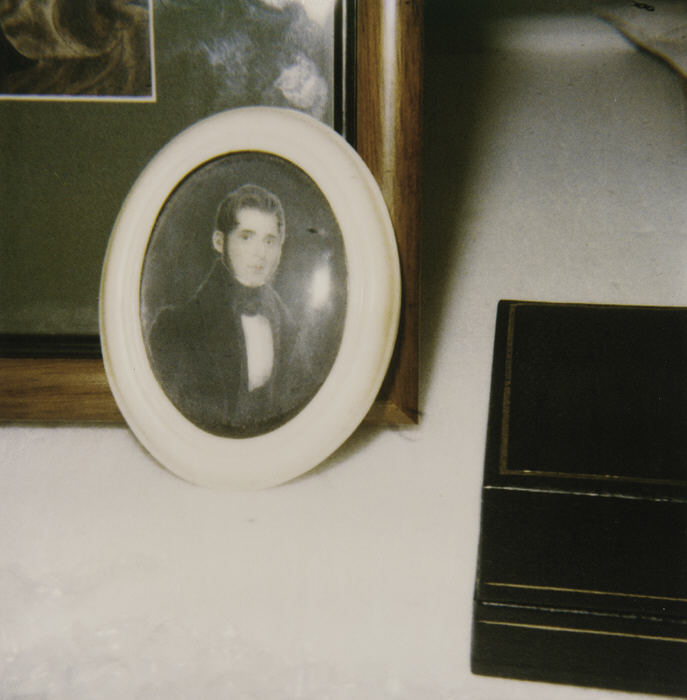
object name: painting, miniature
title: Portrait of a Gentleman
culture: american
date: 1845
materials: ivory, watercolor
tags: men,portraits